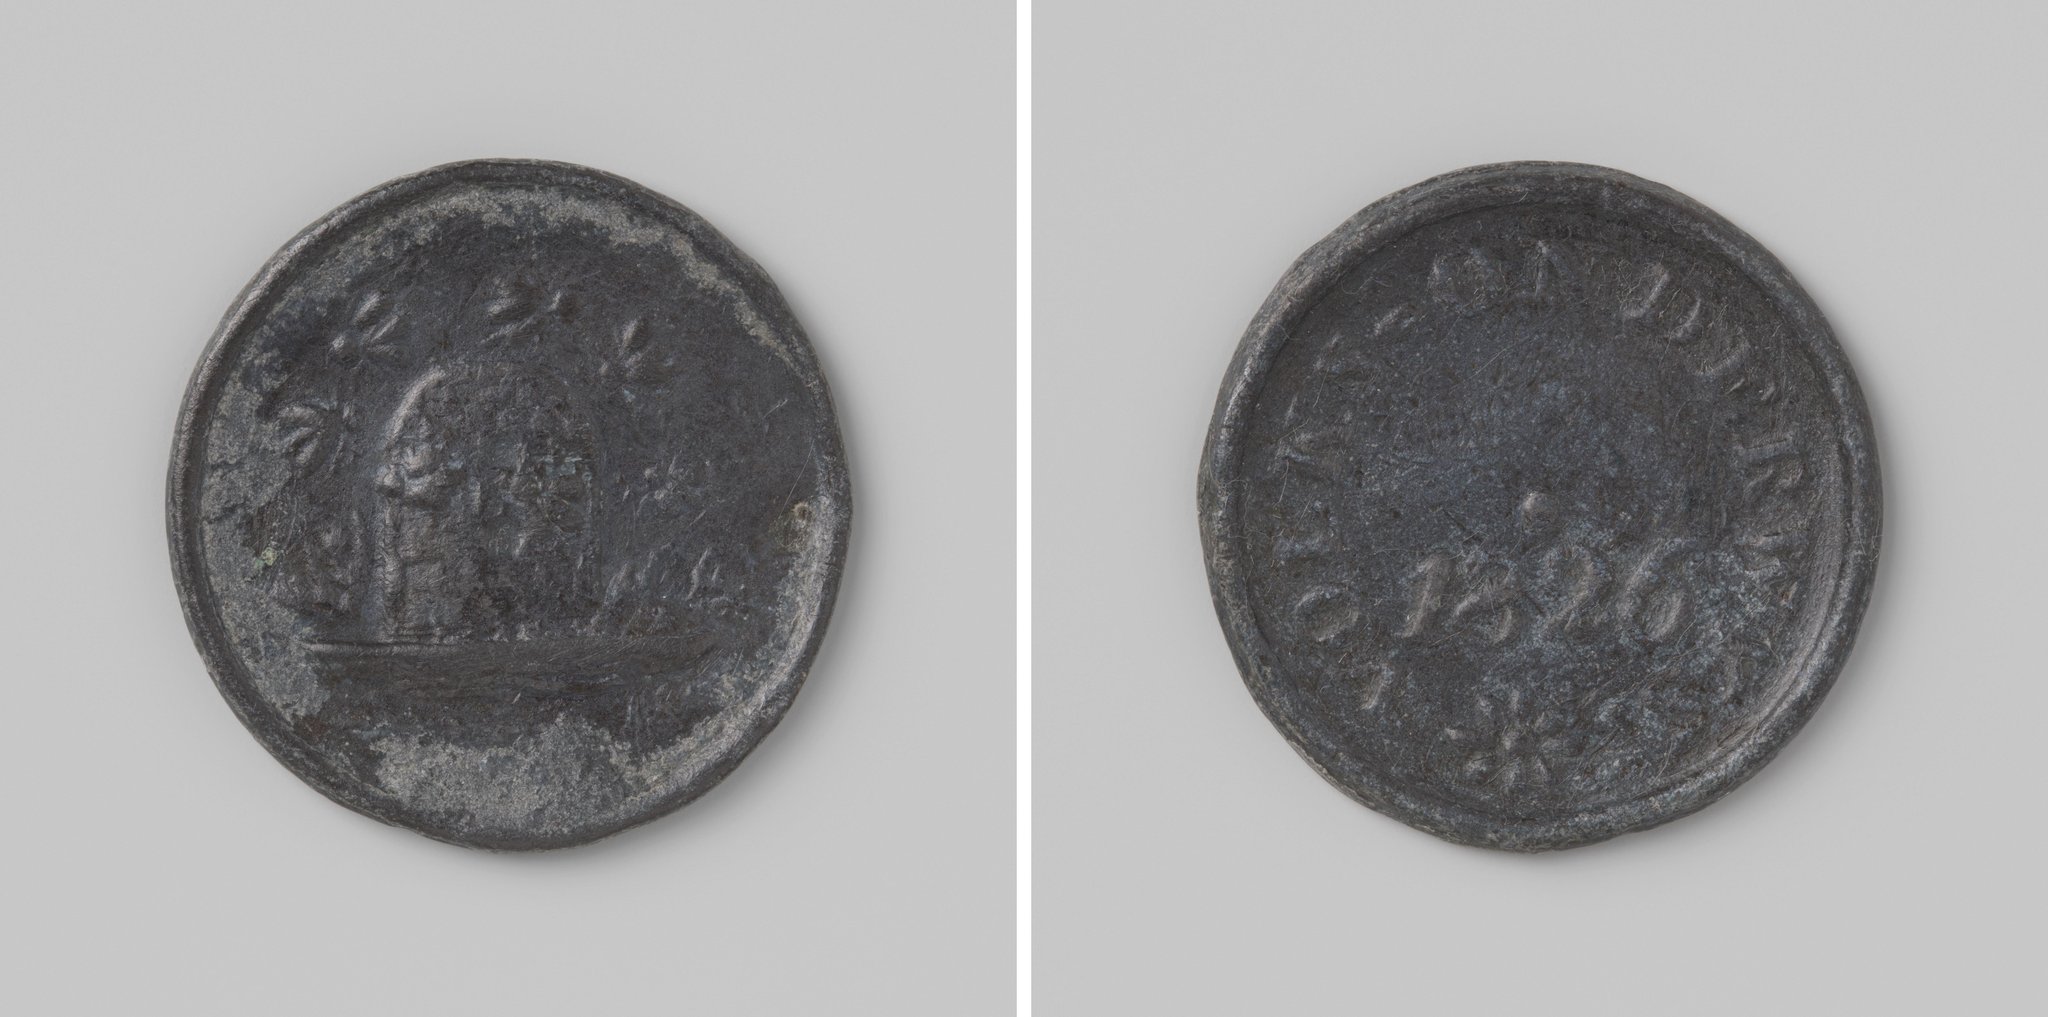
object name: toegangspenning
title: Instituut tot volksonderwijs in de wis- en natuurkunde van de Afdeling Amsterdam der Maatschappij tot Nut van 't Algemeen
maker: Anonymous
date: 1826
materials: lead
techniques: casting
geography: amsterdam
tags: amsterdam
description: Loden penning. Voorzijde: bijenkorf, waaromheen bijen vliegen. Keerzijde: jaartal binnen omschrift